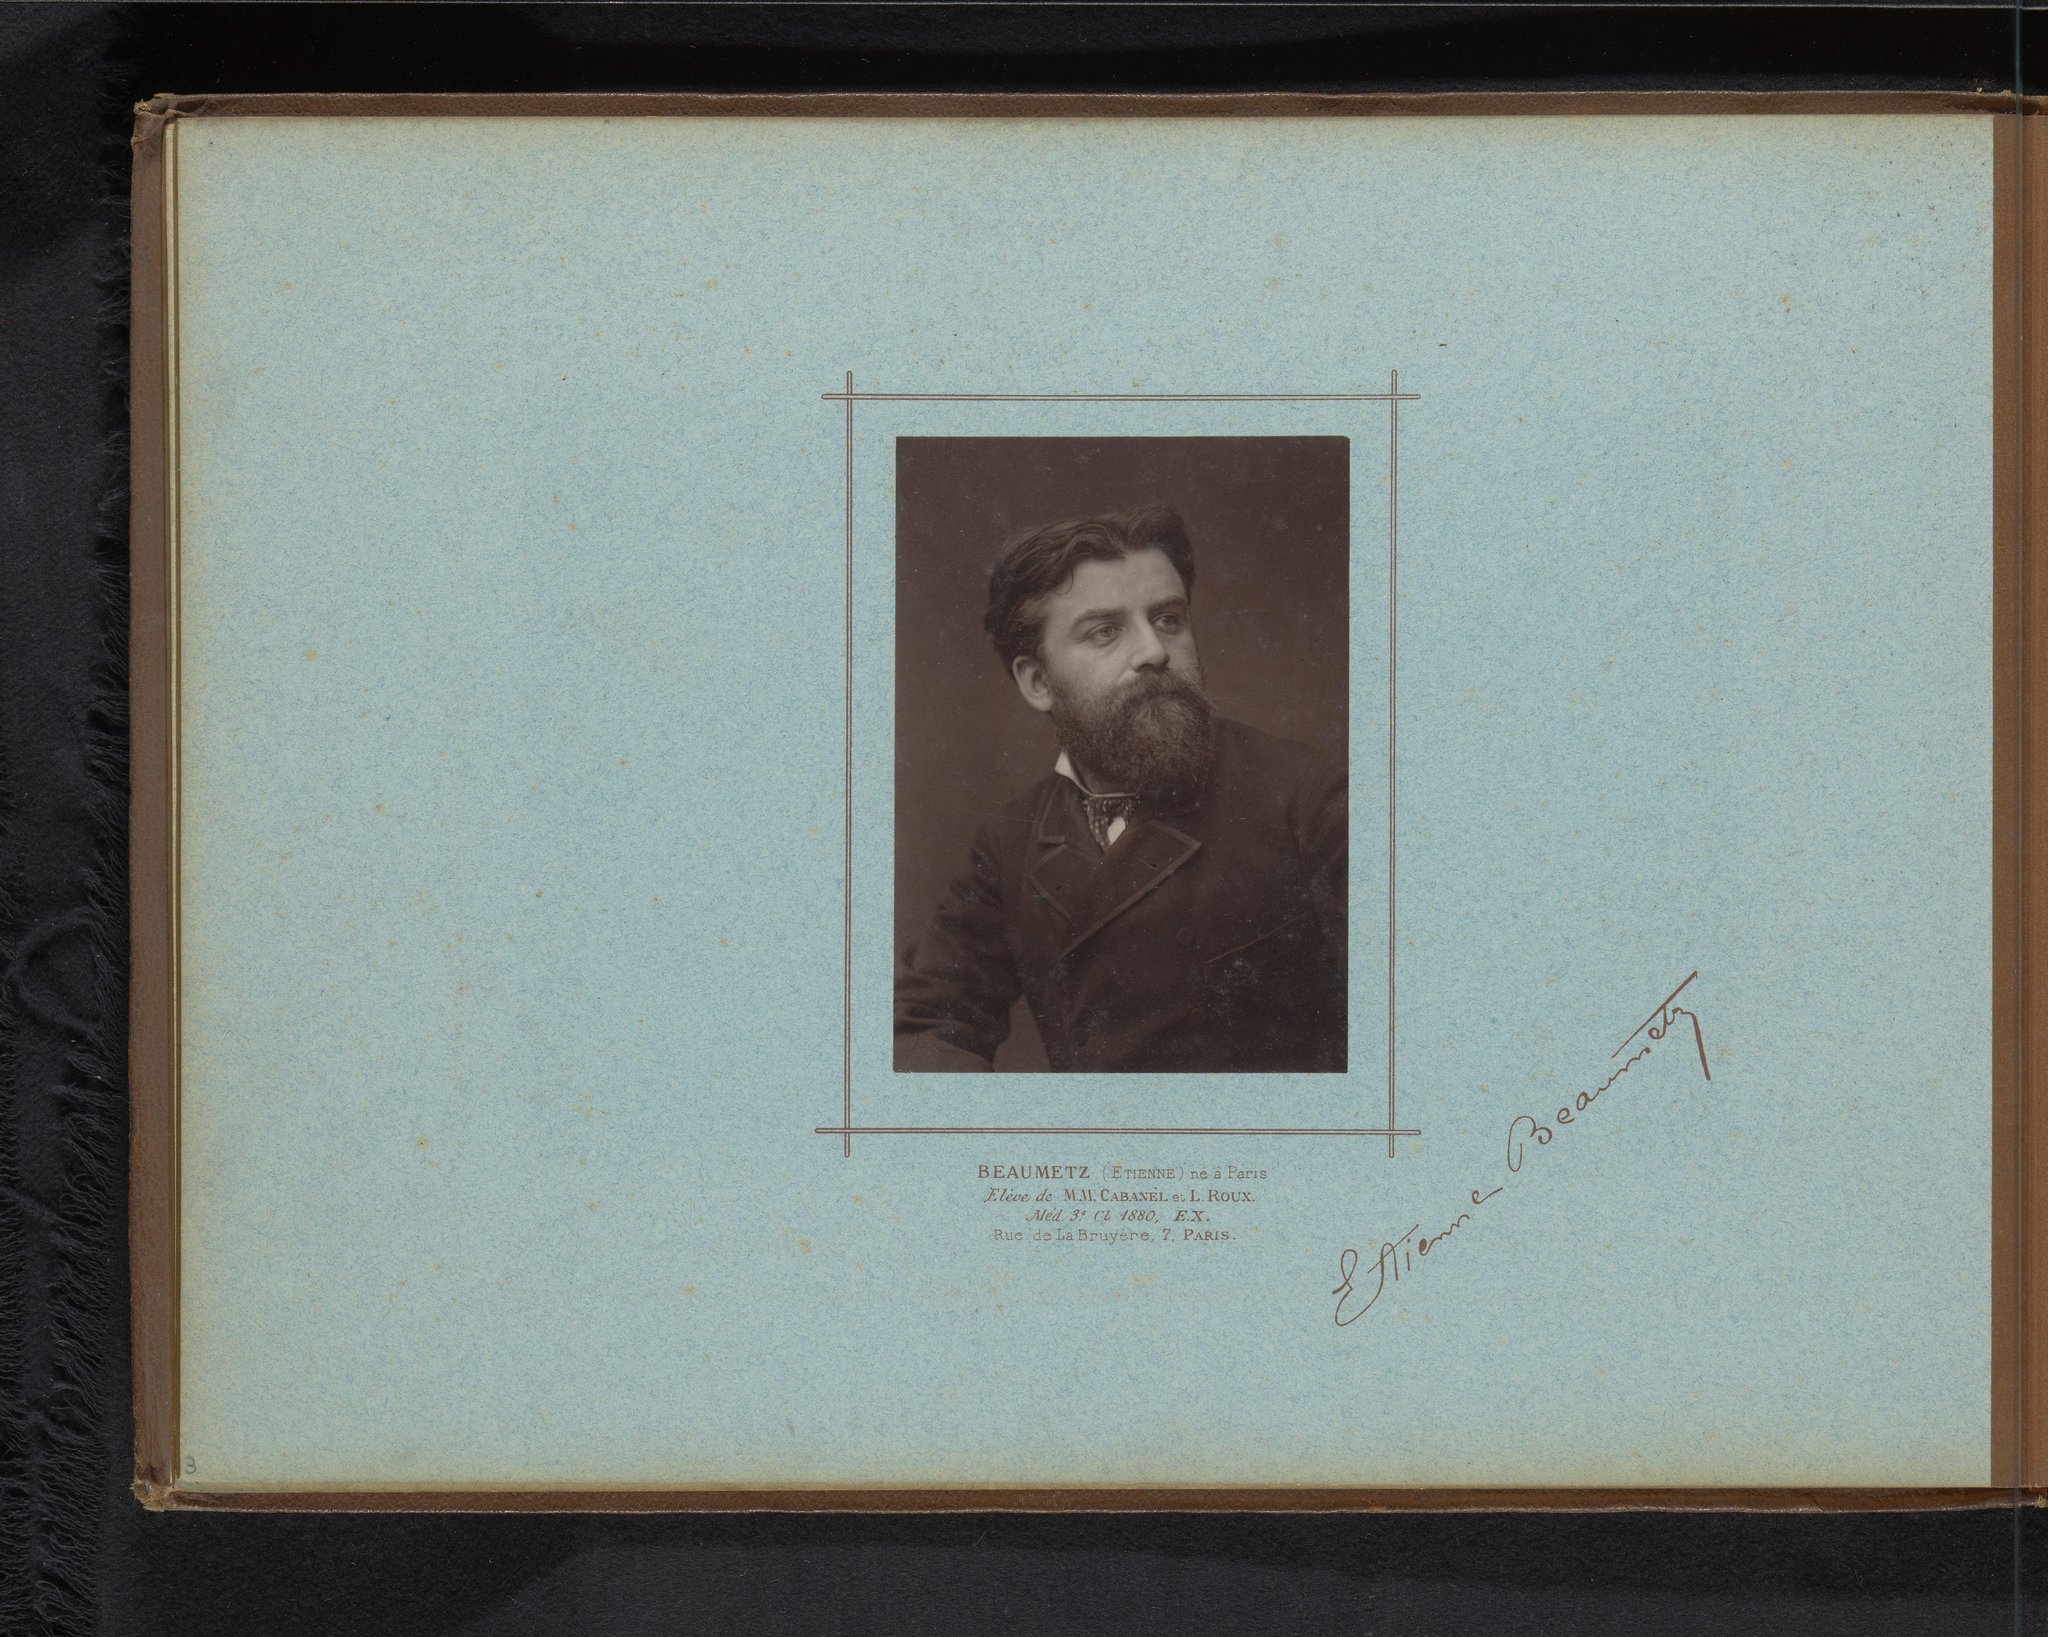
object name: photomechanical print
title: Portret van Etienne Beaumetz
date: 1879-1884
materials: paper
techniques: woodburytype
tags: painter, étienne dujardin-beaumetz, historical persons, portrait, self-portrait of painter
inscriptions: inscription: ‘BEAUMETZ (Etienne) né à Paris/ Élève de M.M. Cabanal et L. Roux./ Med. 3e. Cl. 1880, EX./ Rue de La Bruyère, 7, Paris.’, signature: ‘Etienne Beaumetz’